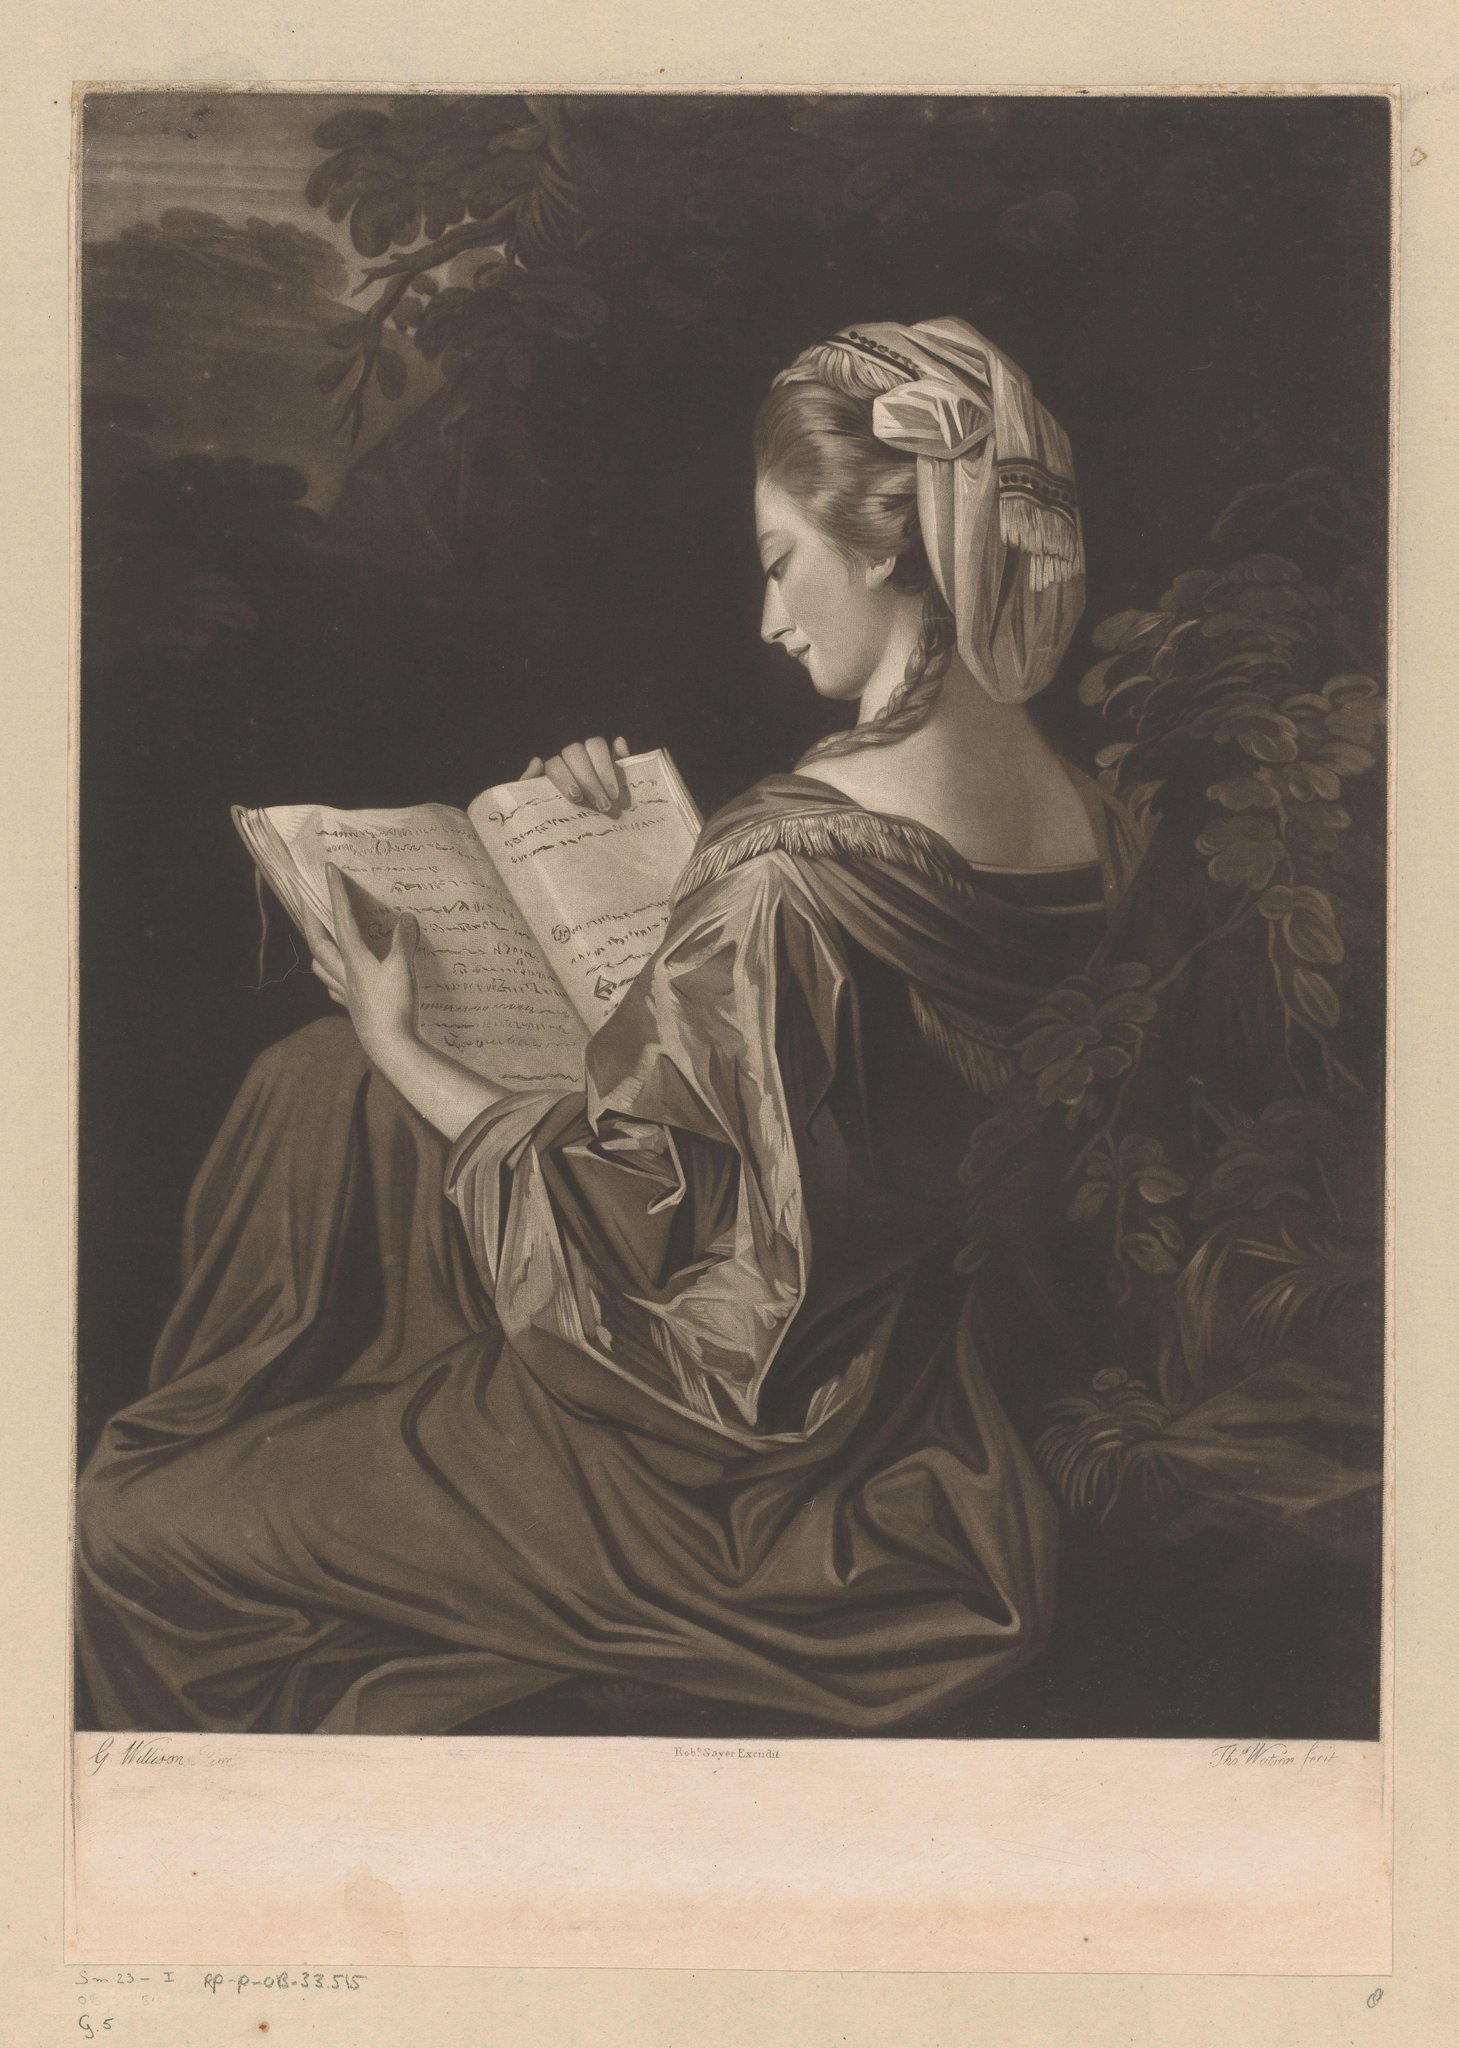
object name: print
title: Portret van mevrouw Lumsdon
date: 1770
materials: paper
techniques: mezzotint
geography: london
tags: reading, historical persons - bb - woman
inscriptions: collector's mark: Lugt 240